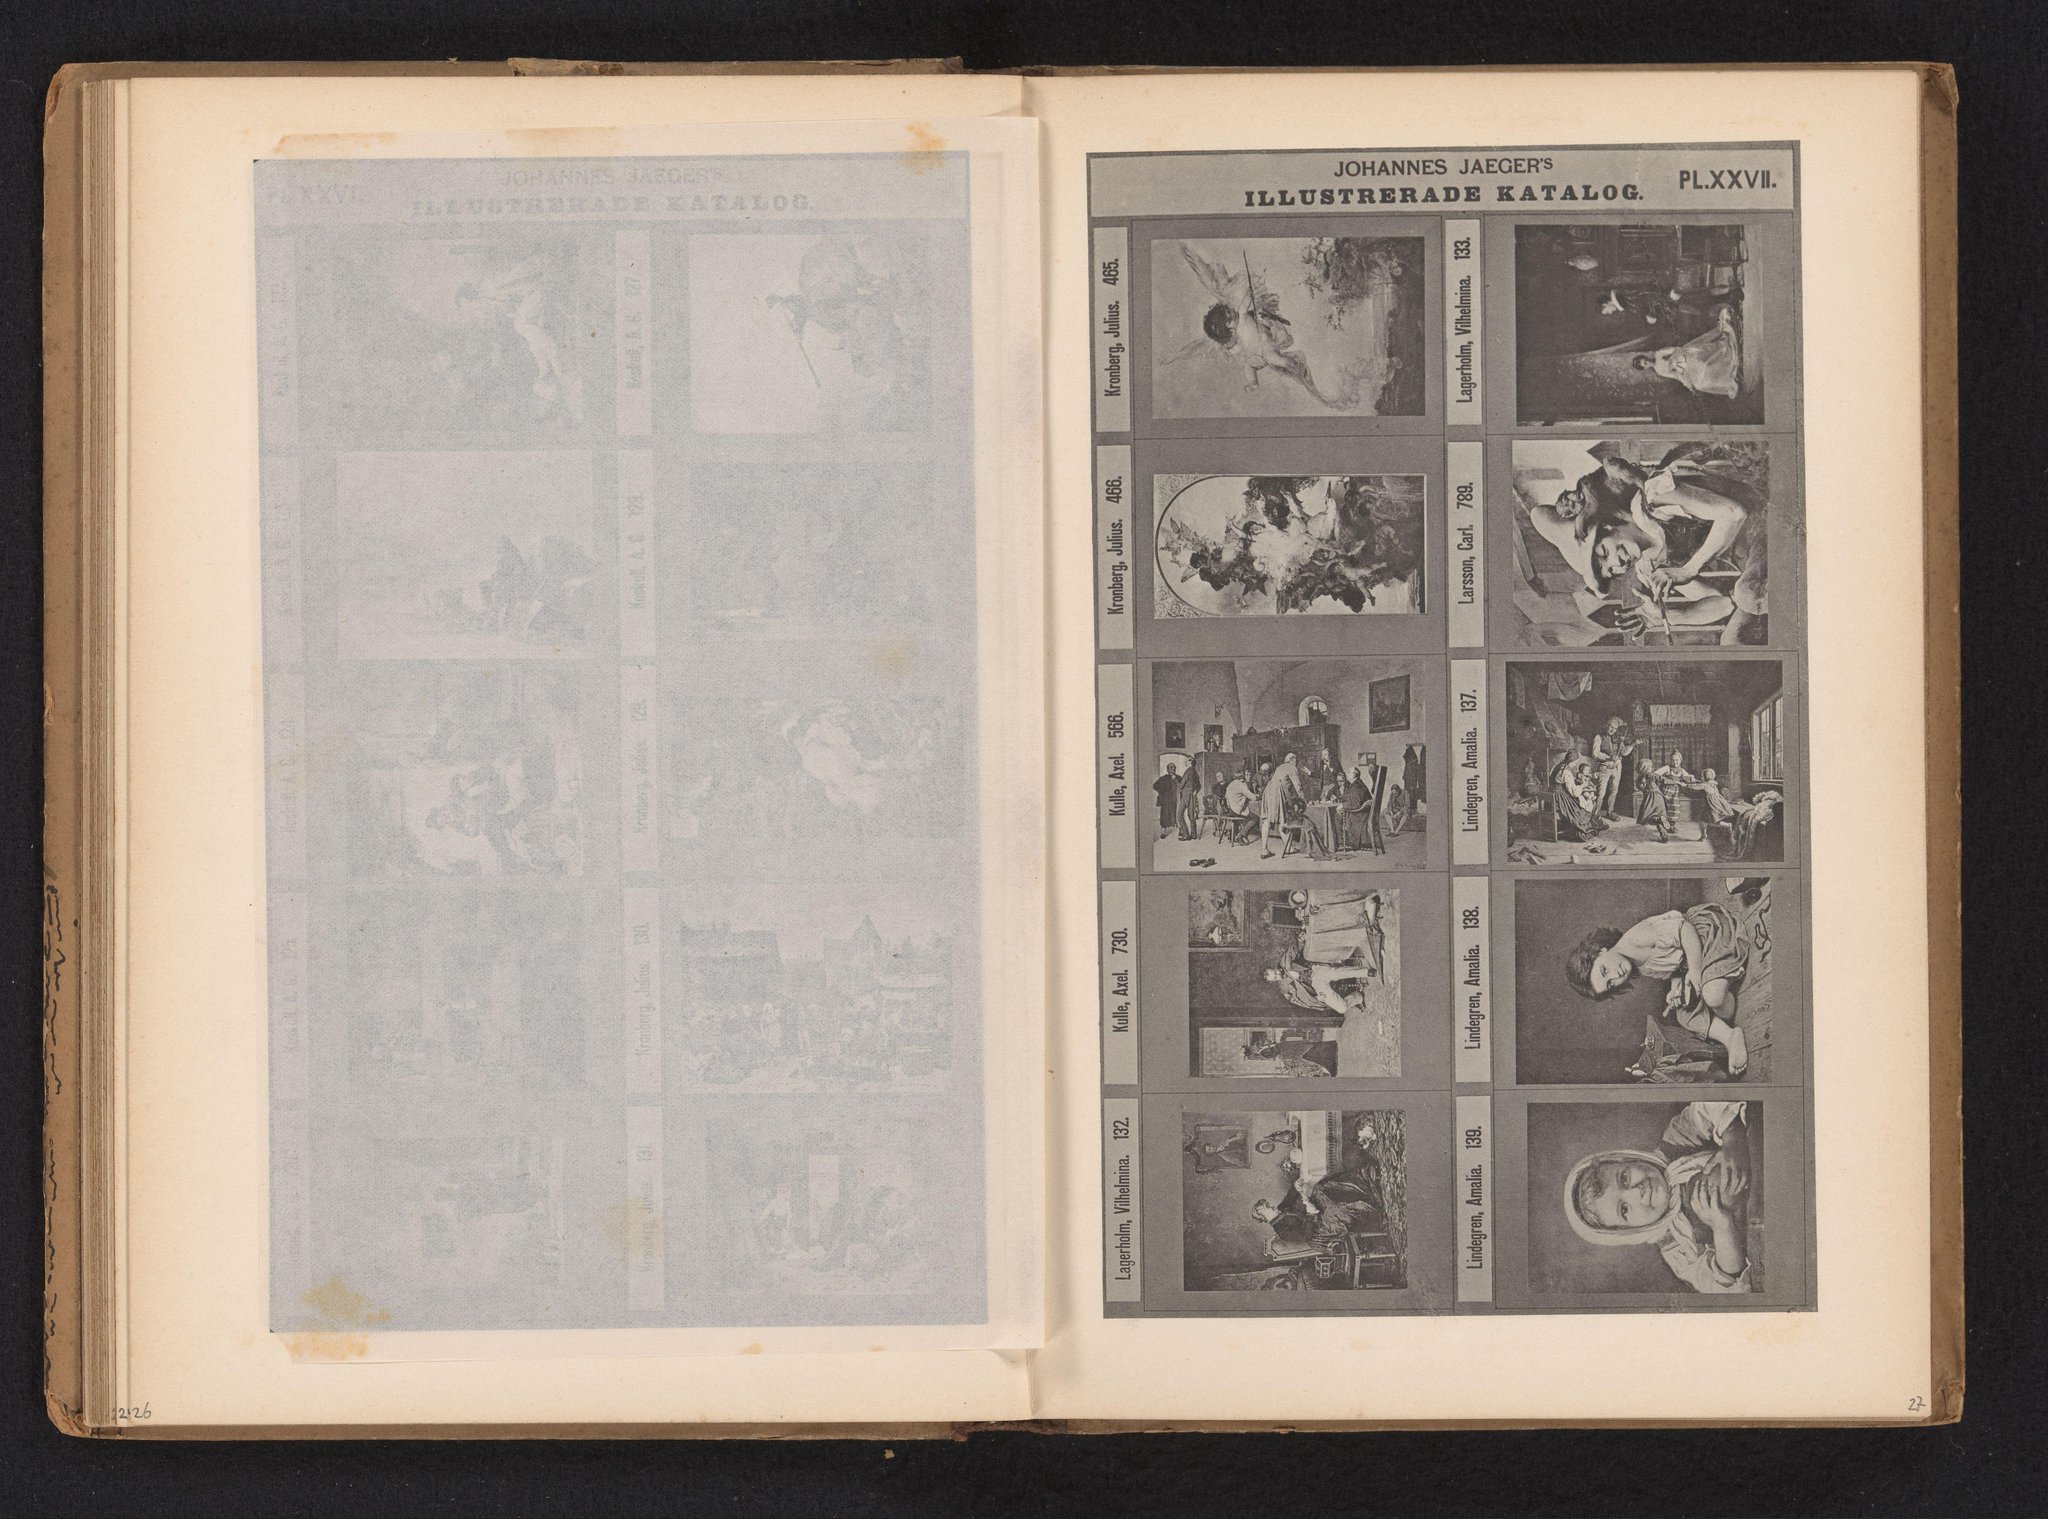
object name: reproduction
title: Fotoreproductie van tien schilderijen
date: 1872-1882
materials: paper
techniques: photograph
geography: stockholm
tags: picture, painting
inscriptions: number: ‘PL. XXVII.’